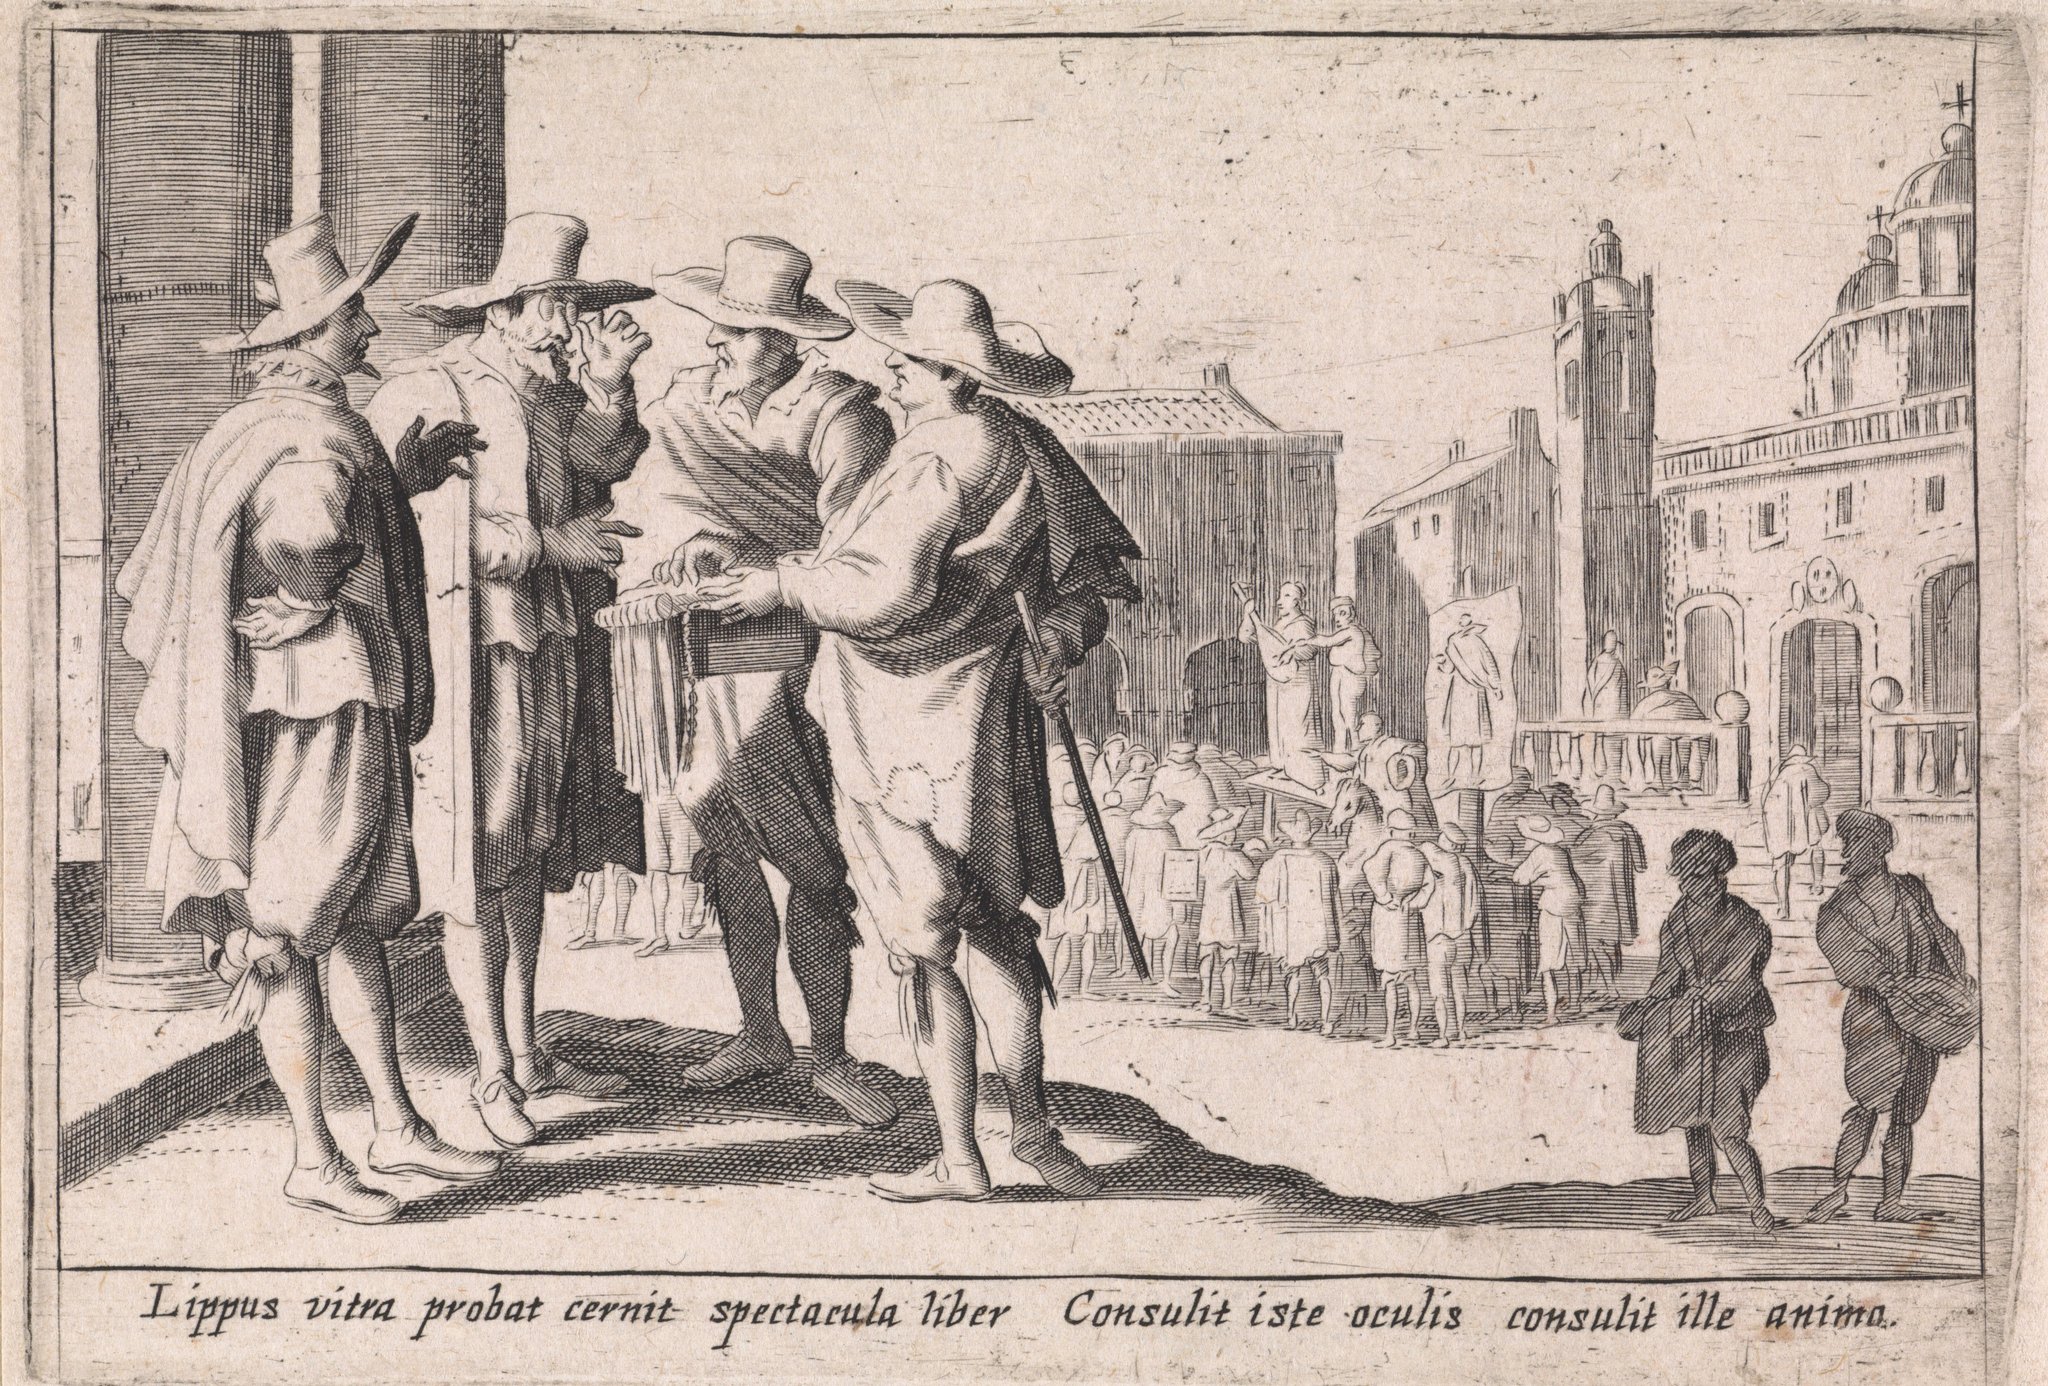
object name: print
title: Italiaanse handwerkslieden en verkopers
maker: Anonymous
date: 1613-1667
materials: paper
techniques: engraving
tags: eyeglasses, spectacles, merchant, salesman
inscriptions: collector's mark: Lugt 240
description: Een man zet een bril op zijn neus, die een brillenverkoper hem aanbiedt. Op de achtergrond toeschouwers rond een muzikant op een plein. In de marge een onderschrift in het Latijn.